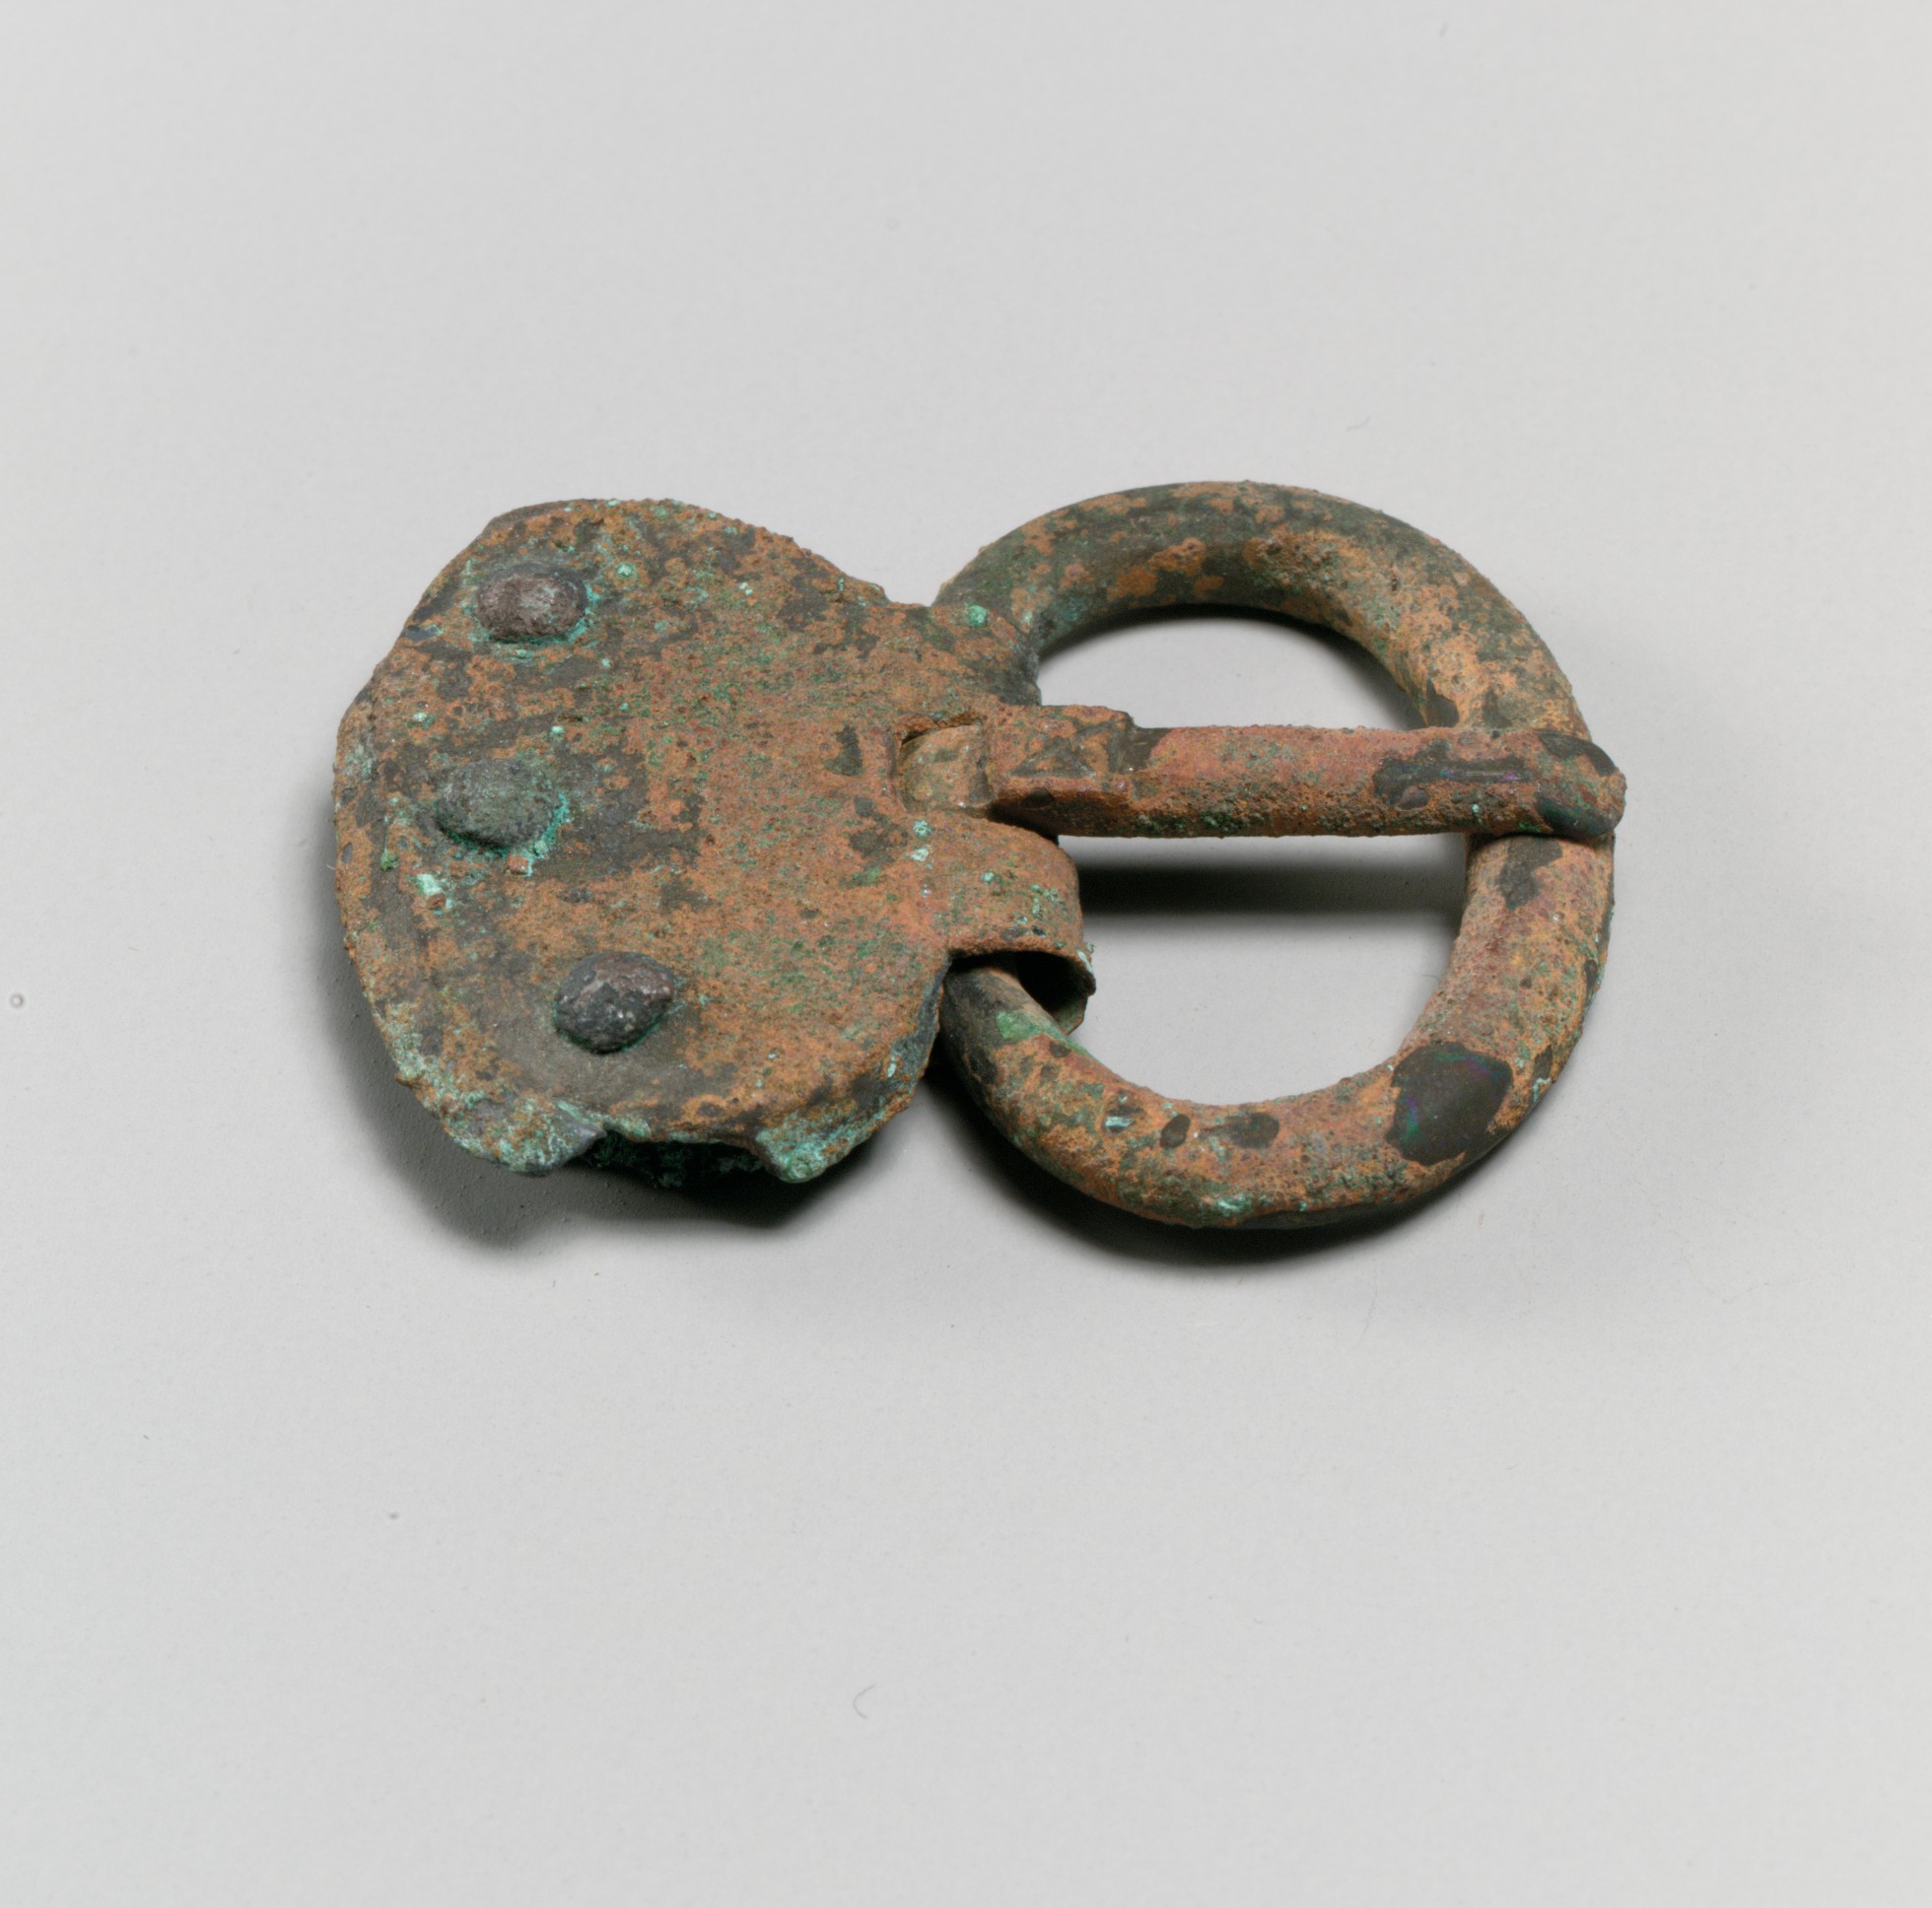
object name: buckle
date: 7000 BCE-330 CE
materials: bronze